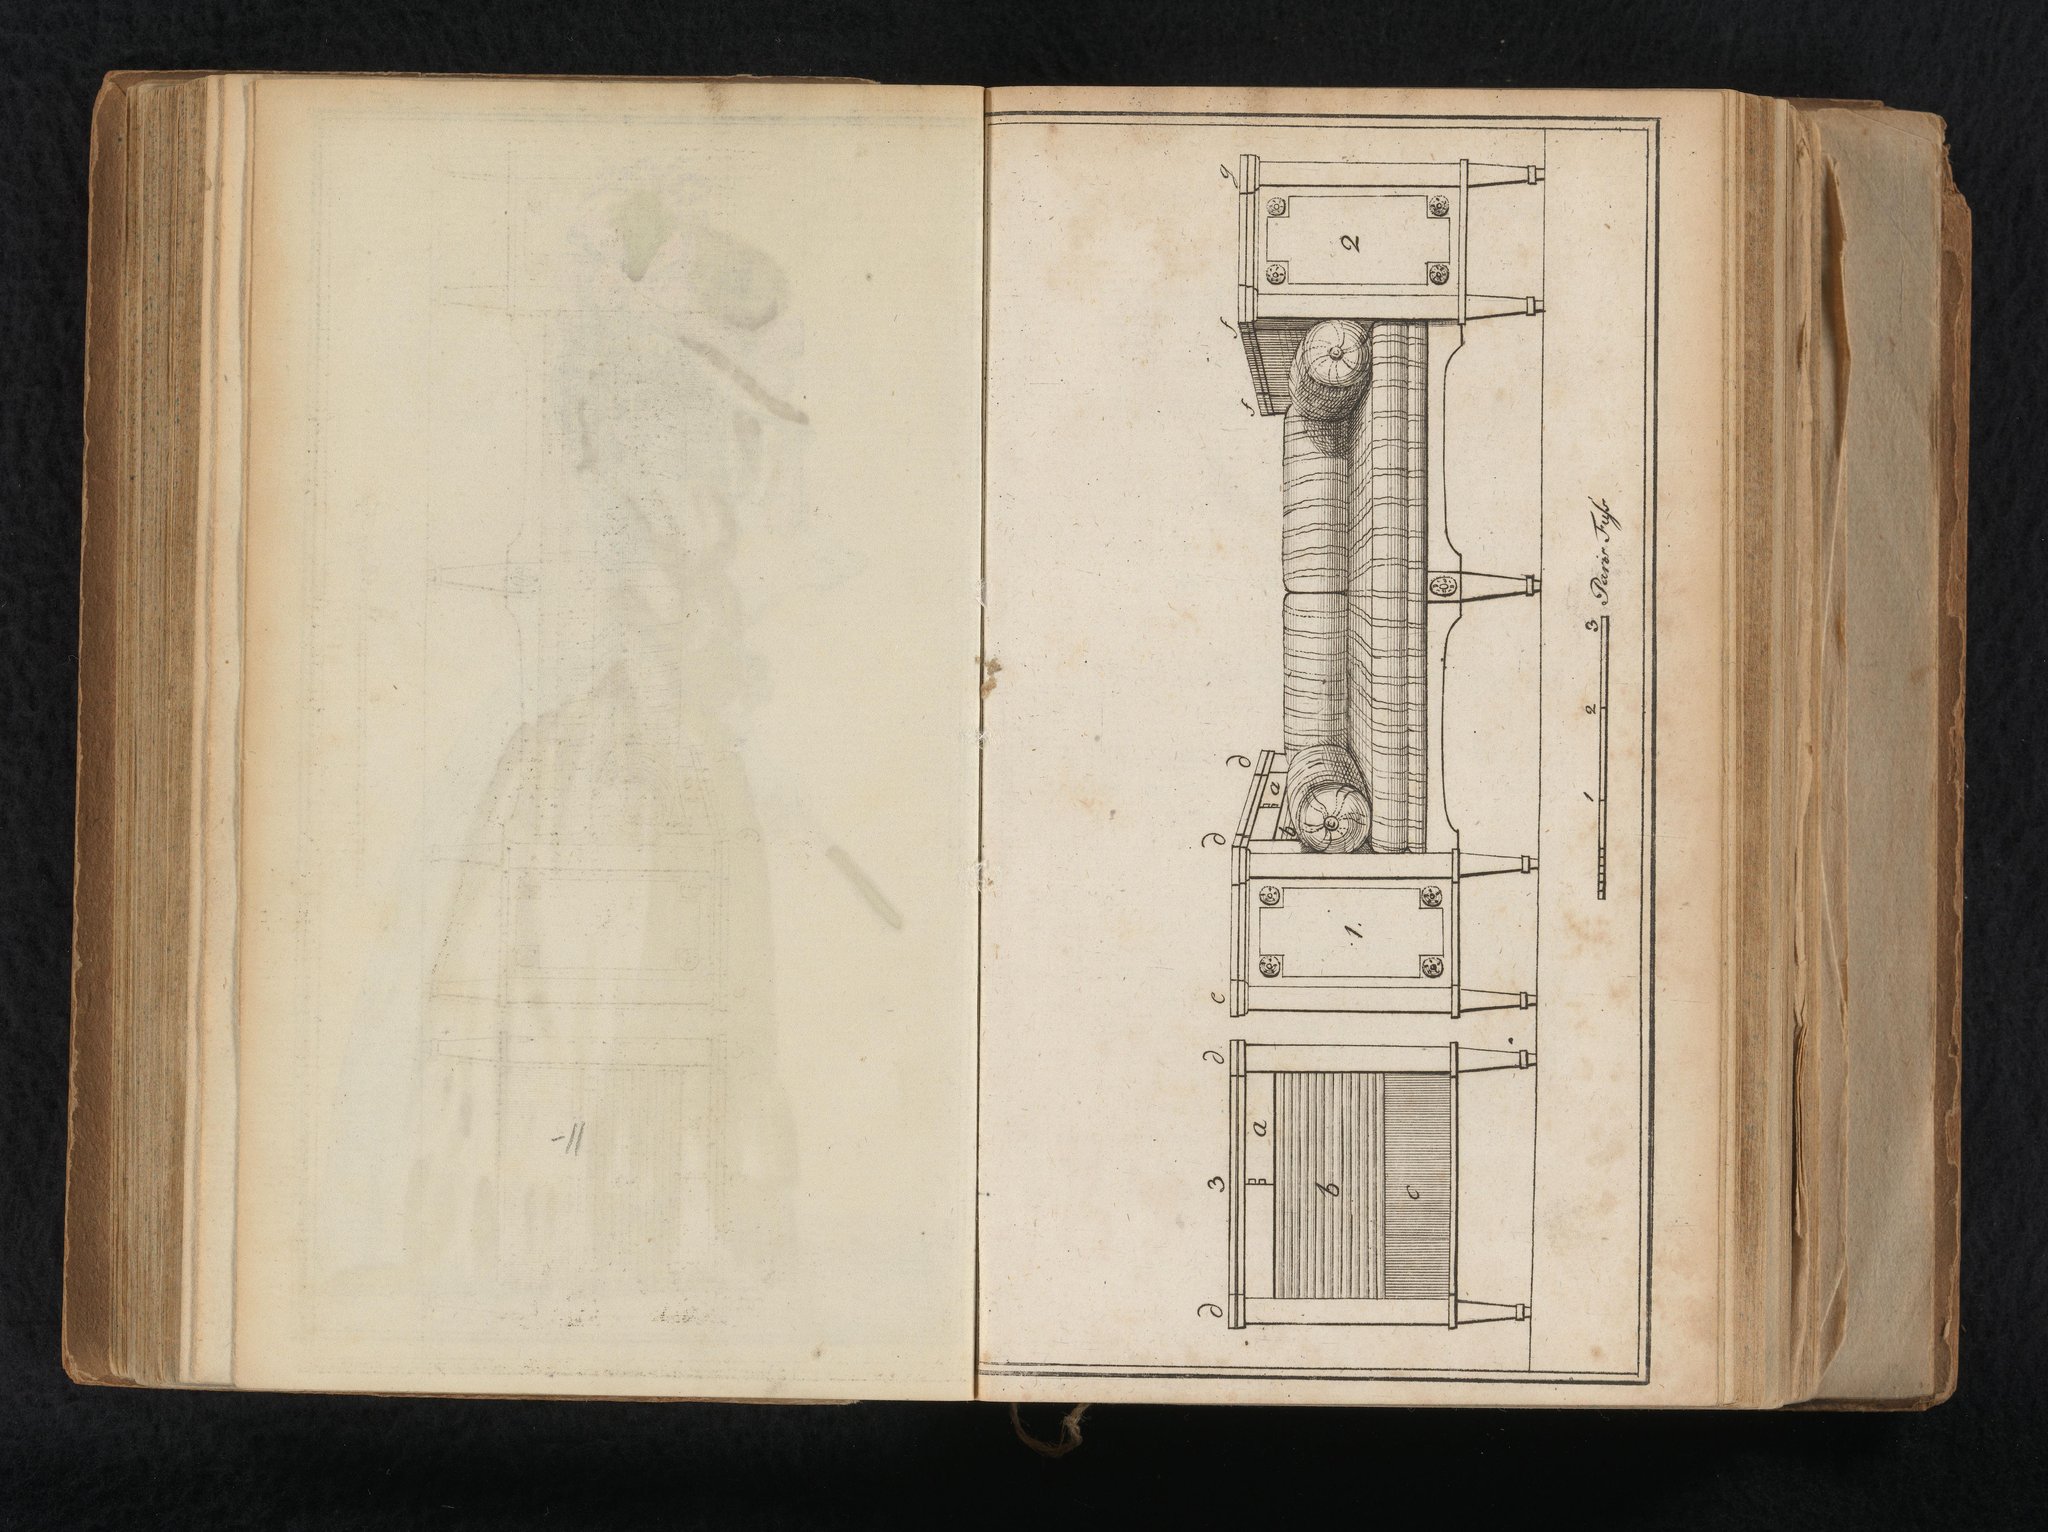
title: Journal des Luxus und der Moden 1788, Band III, T.12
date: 1788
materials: paper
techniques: etching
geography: weimar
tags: fashion plates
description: Ameublement. Prent uit het modetijdschrift Journal des Luxus und der Moden, uitgegeven door Friedrich Justin Bertuch en Georg Melchior Kraus, Weimar, 1786-1826.